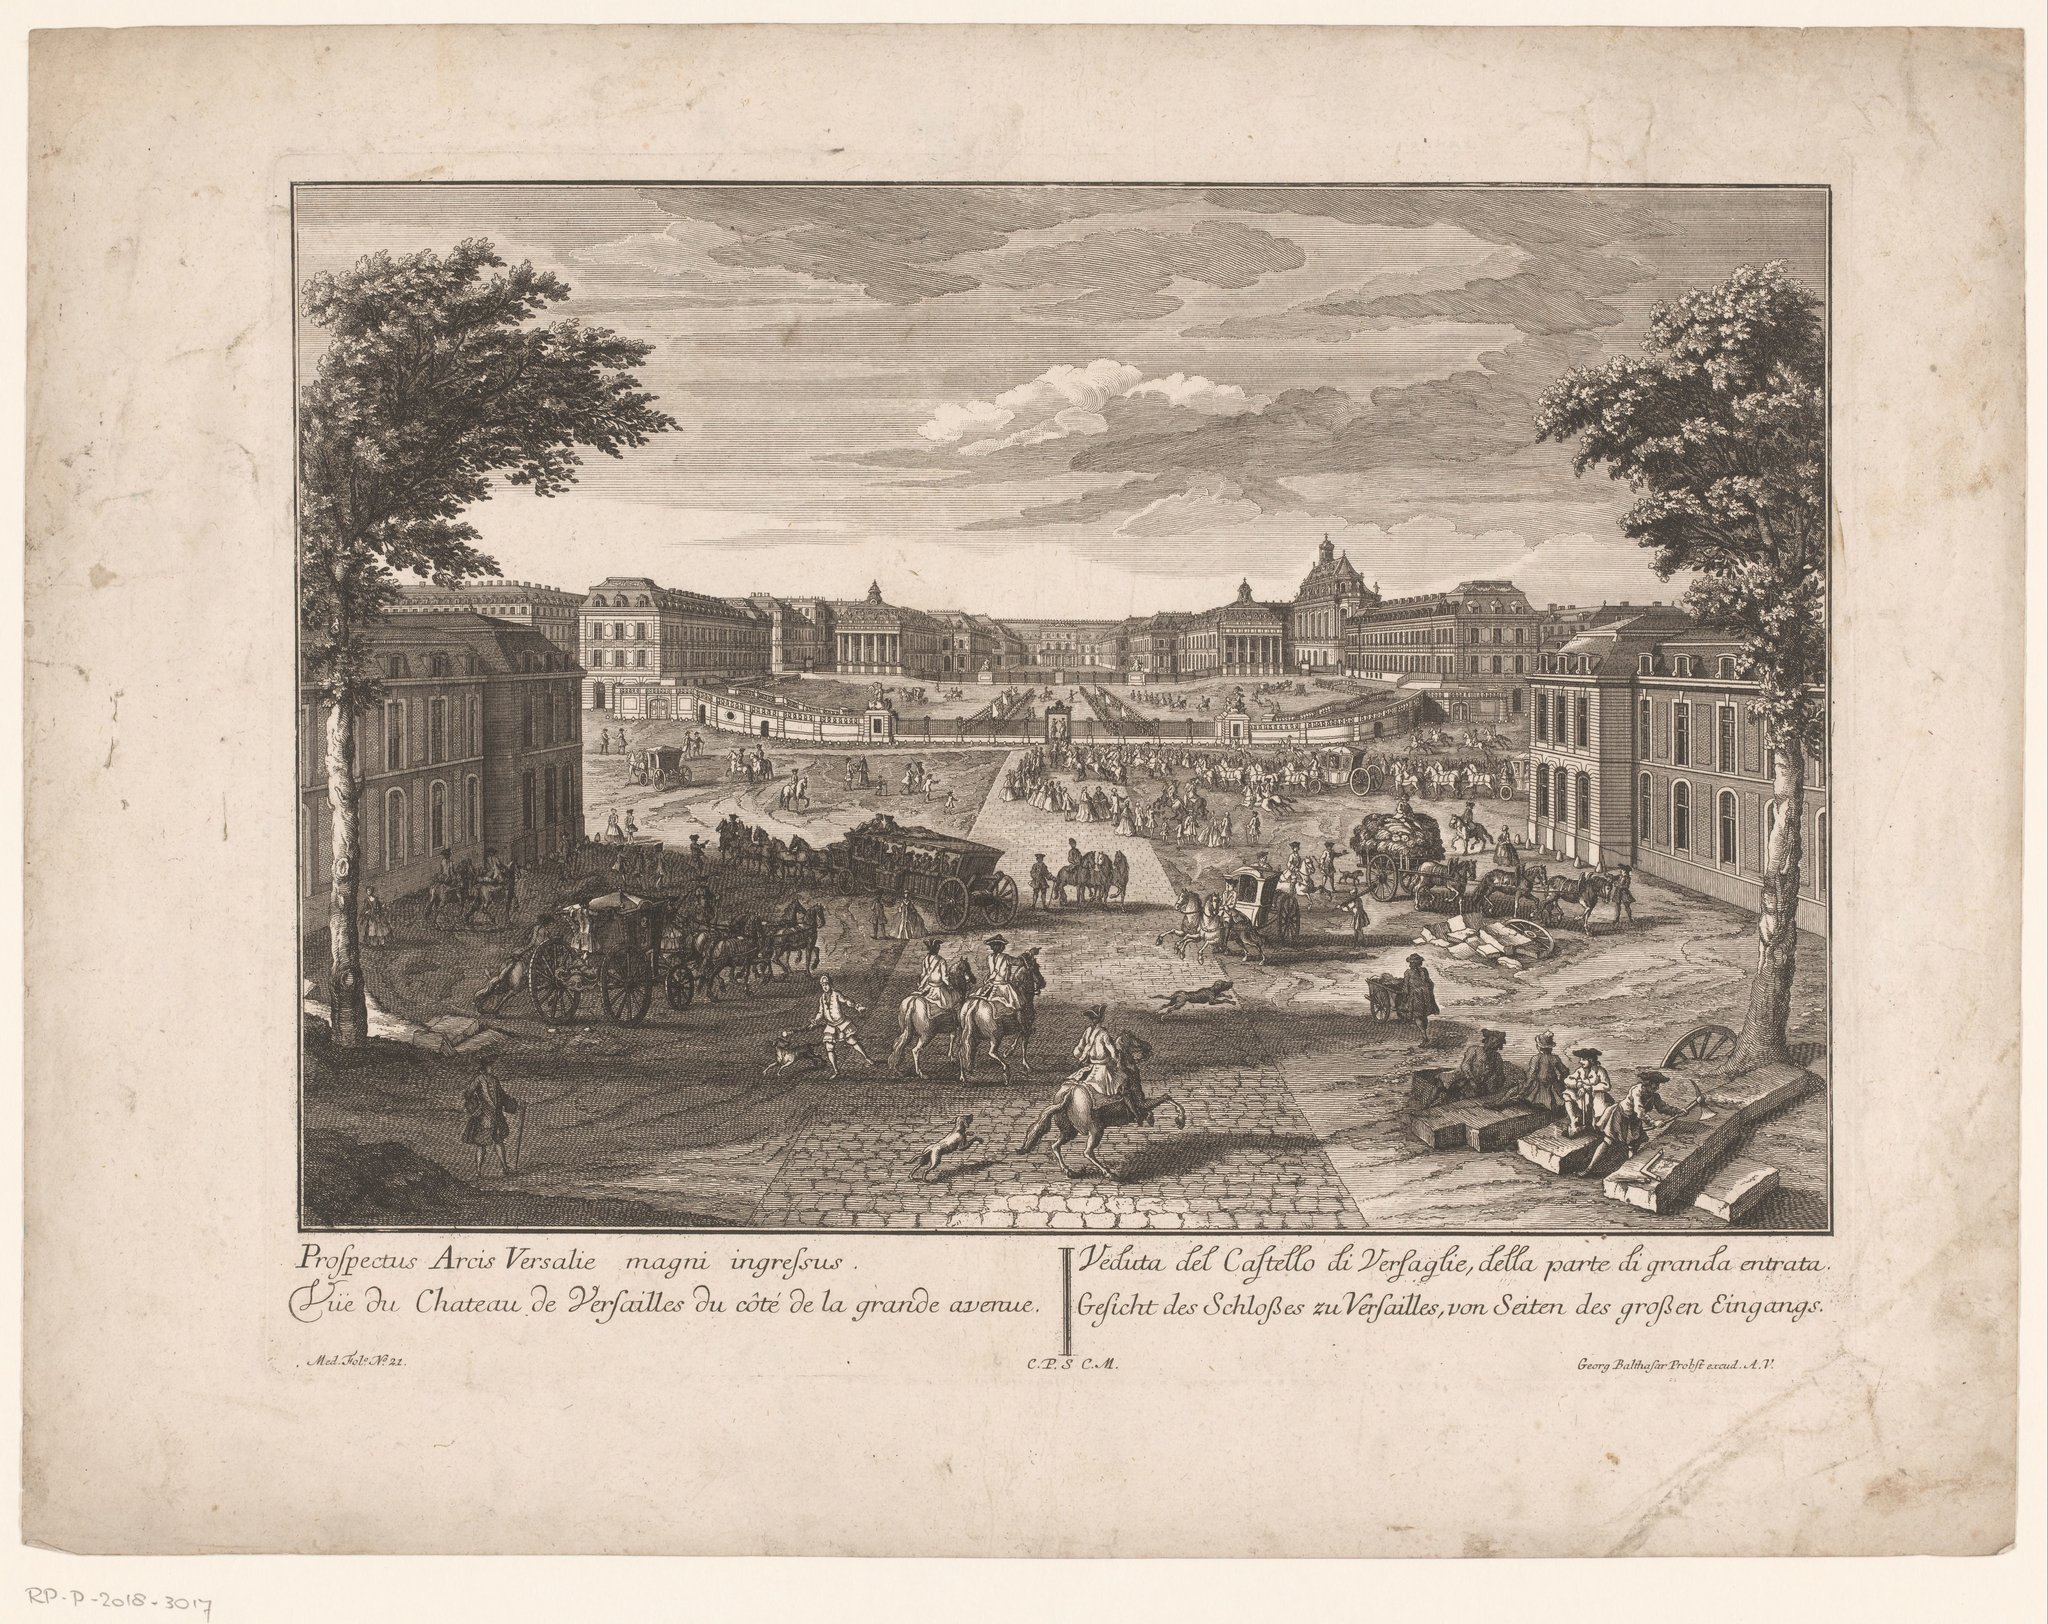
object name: print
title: Gezicht op het Paleis van Versailles van de zijde van de brede allée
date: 1742-1801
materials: paper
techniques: engraving, etching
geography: augsburg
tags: palace, landscape with tower or castle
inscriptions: collector's mark: Lugt 2228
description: Links onderin het opschrift Med. Fol[i]o No. 21.